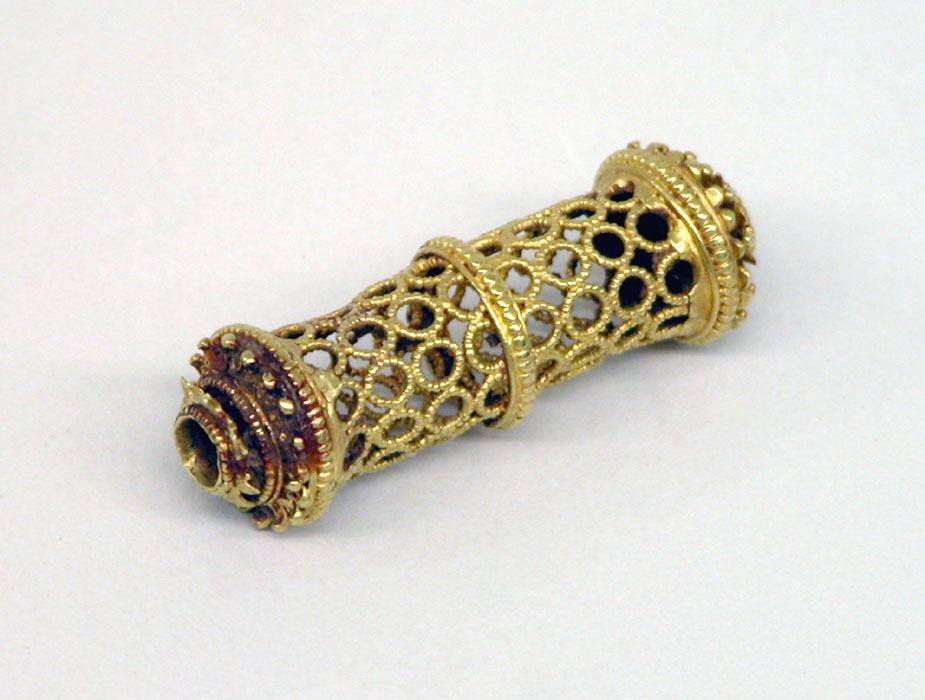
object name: cord clasp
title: Cylindrical Cord Clasp with Filigree Design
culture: indonesian, javanese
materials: gold